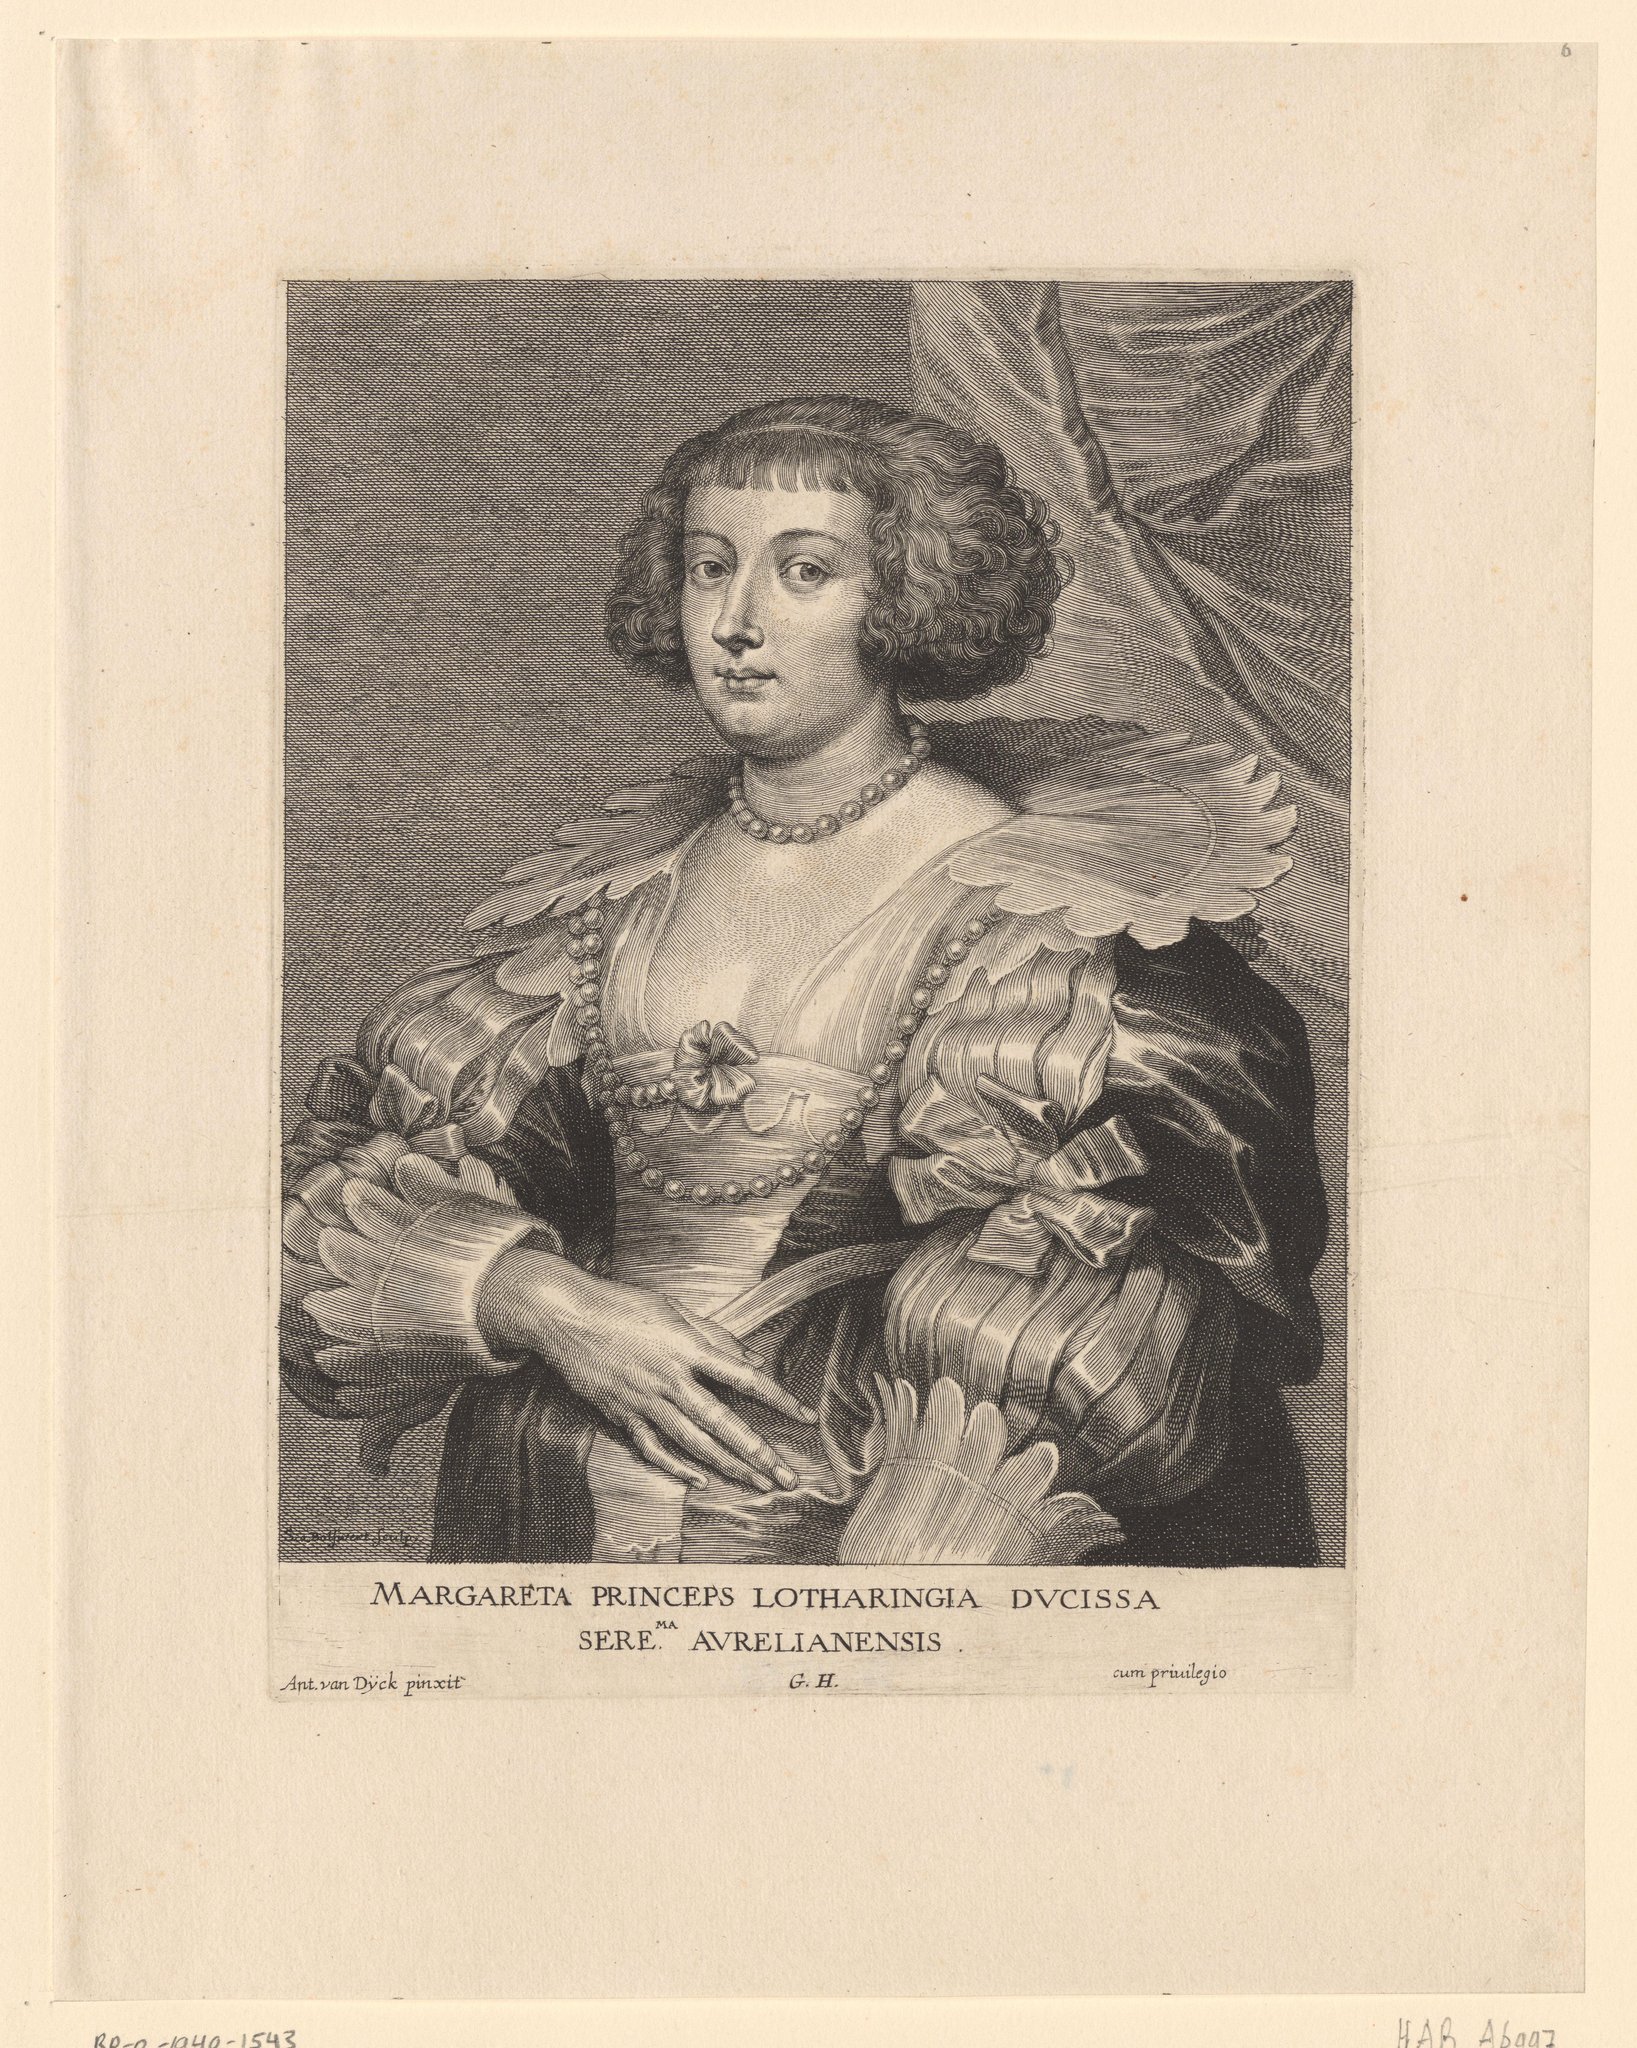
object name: print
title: Iconographie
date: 1645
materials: paper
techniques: engraving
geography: antwerp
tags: paris, margaretha van lotharingen, historical persons - bb - woman, pearl; pearl necklace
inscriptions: collector's mark: Lugt 2166, collector's mark: Lugt 2760, collector's mark: Lugt 2228